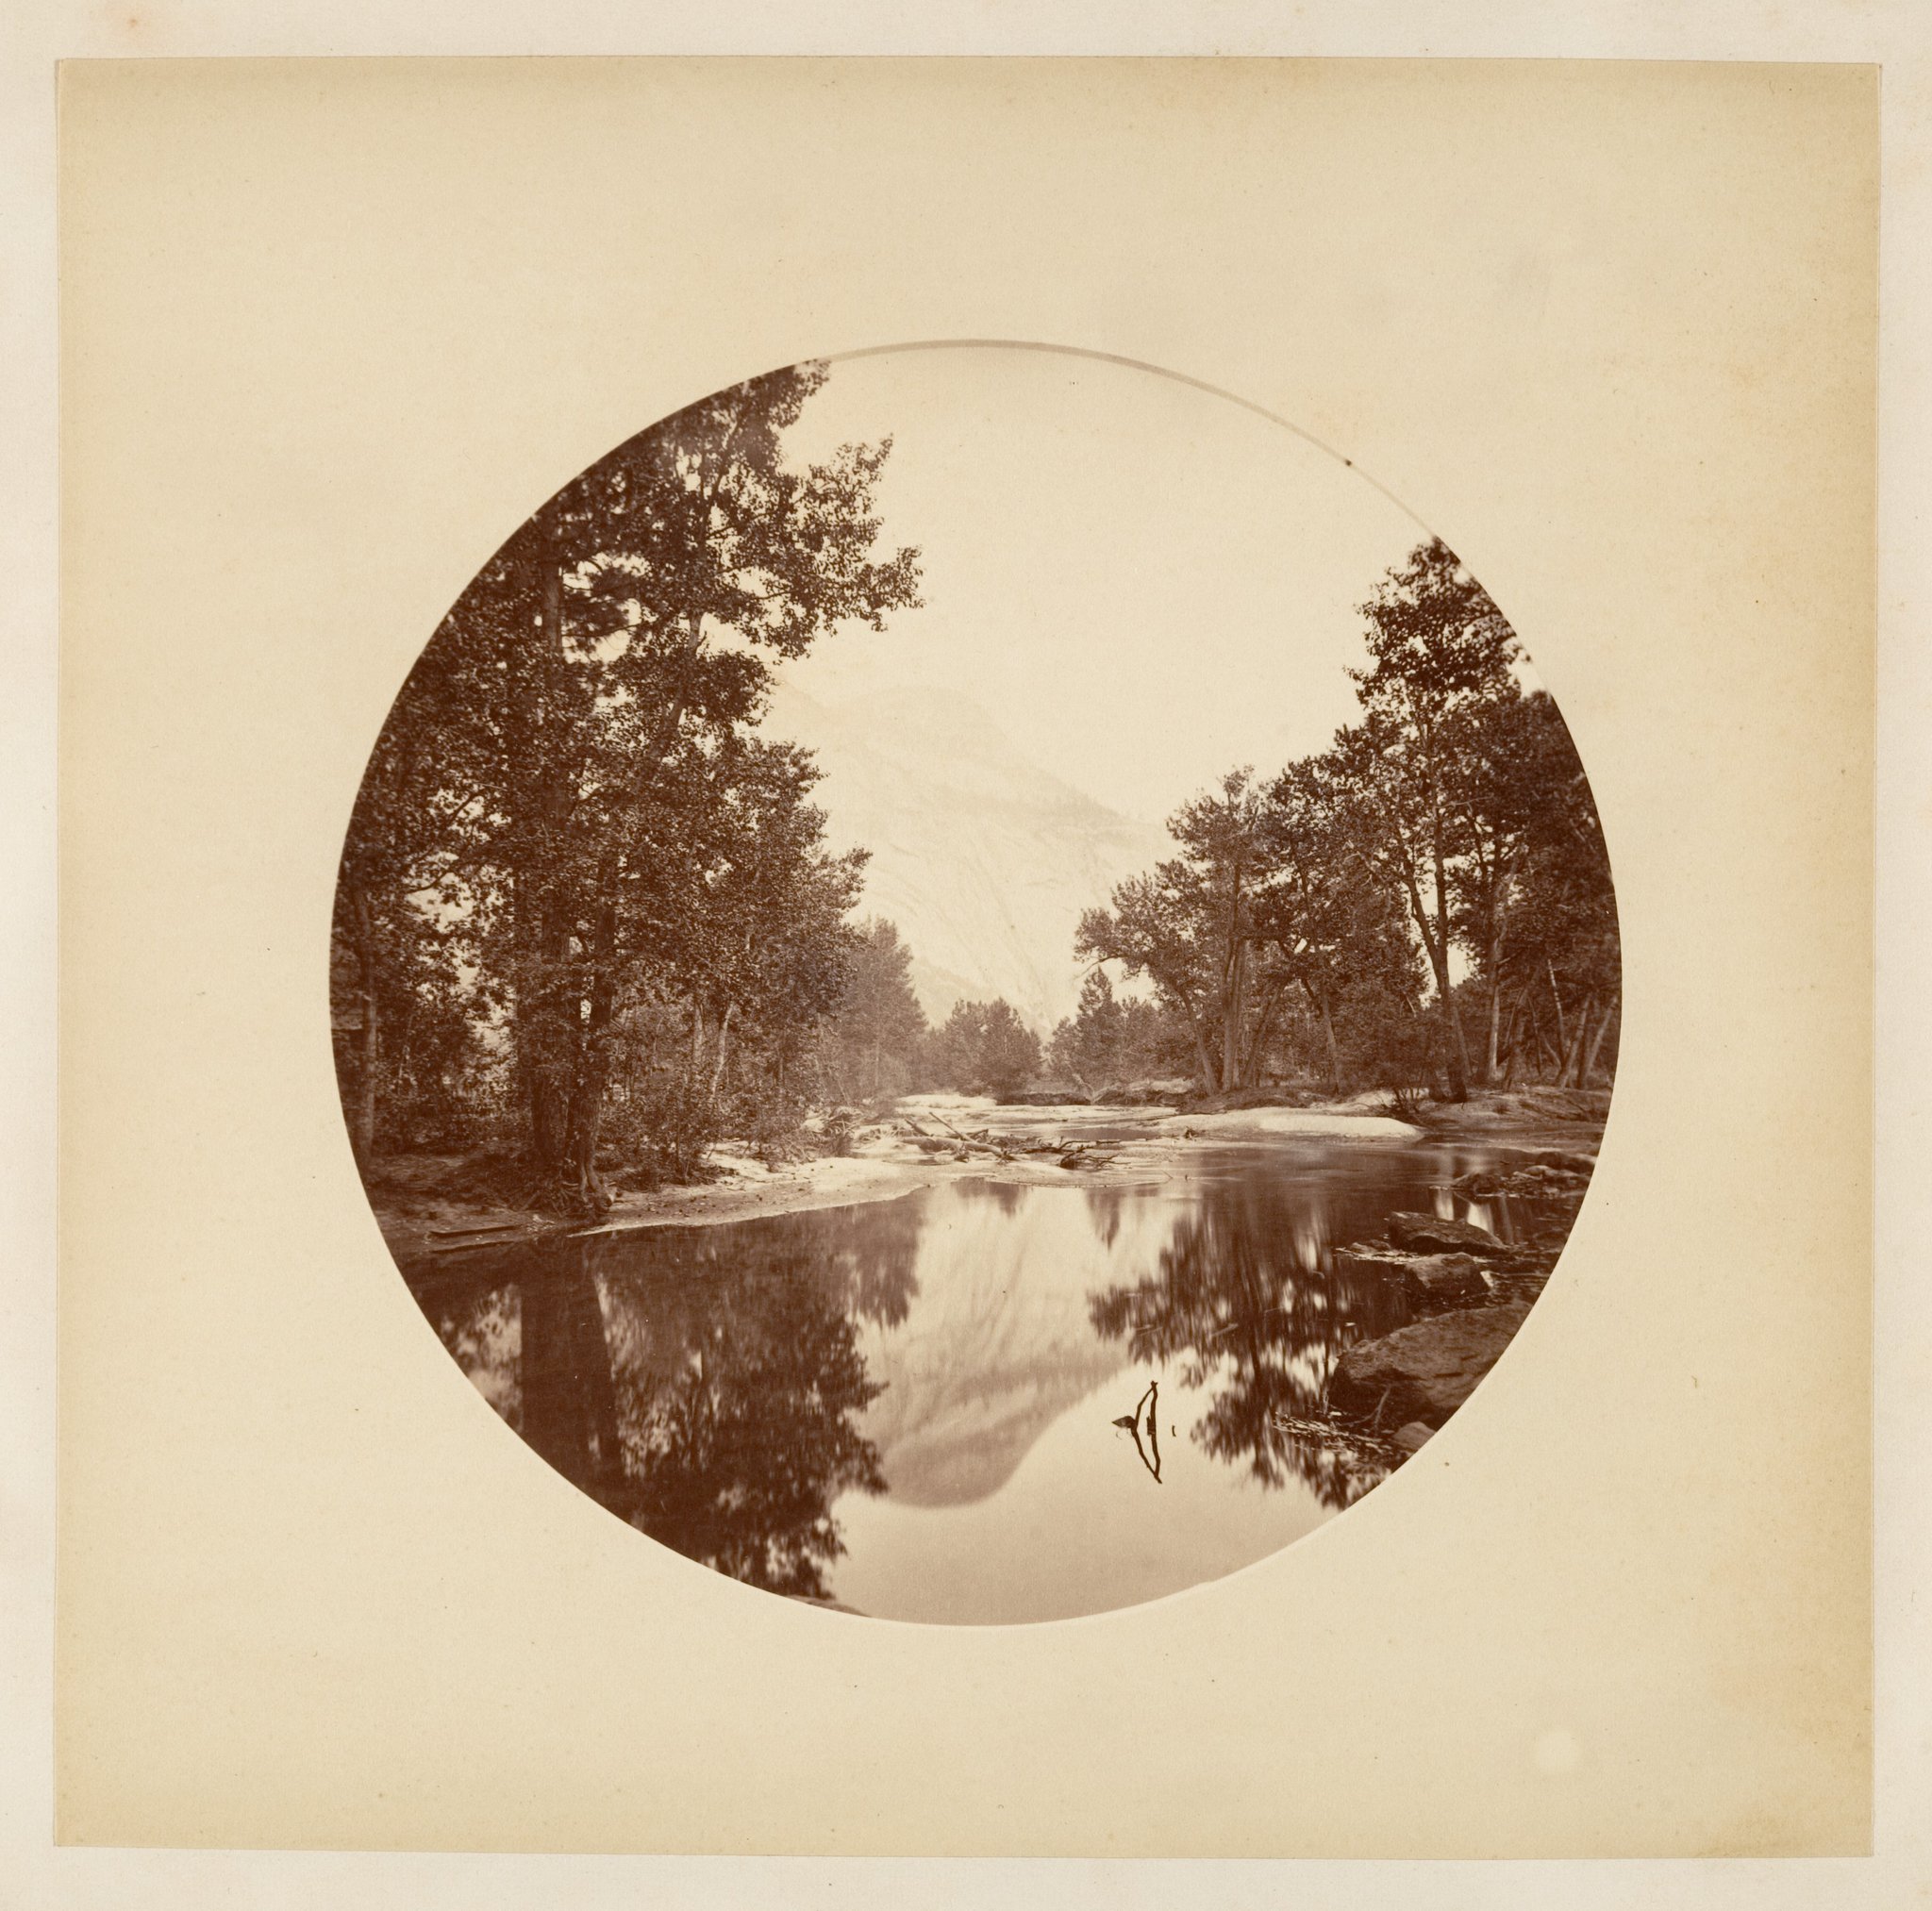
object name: photograph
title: [Yosemite National Park, California]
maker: carleton e. watkins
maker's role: artist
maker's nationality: american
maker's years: 1829-1916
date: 1878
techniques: albumen silver print, glass negative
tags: landscapes